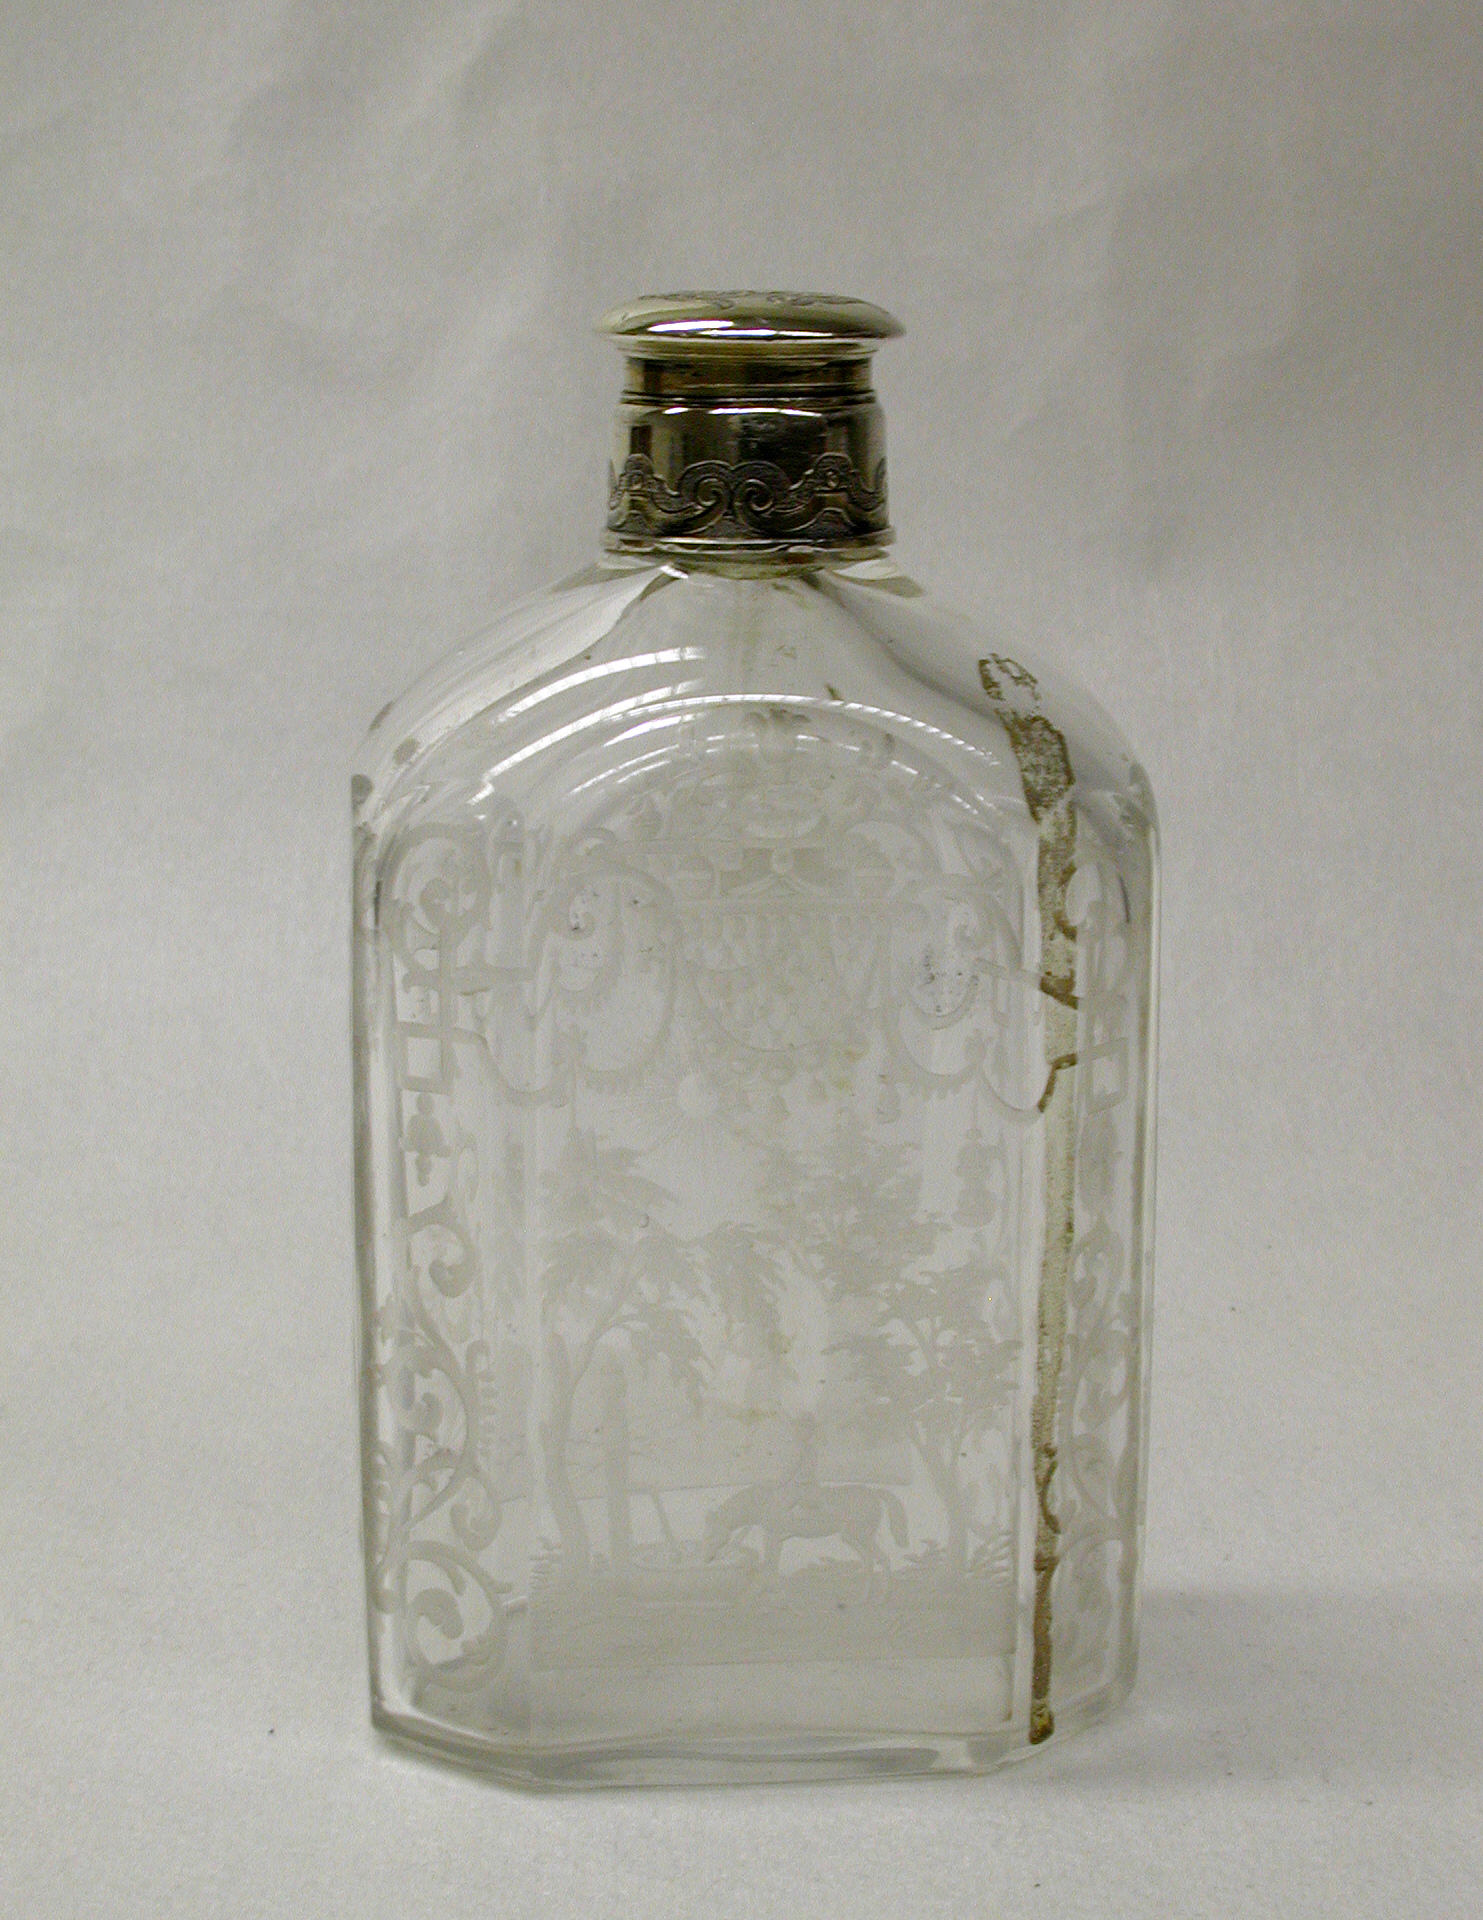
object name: flask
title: Flask (one of a pair)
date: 1701-1800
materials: glass, silver gilt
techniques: cutting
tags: horses,trees